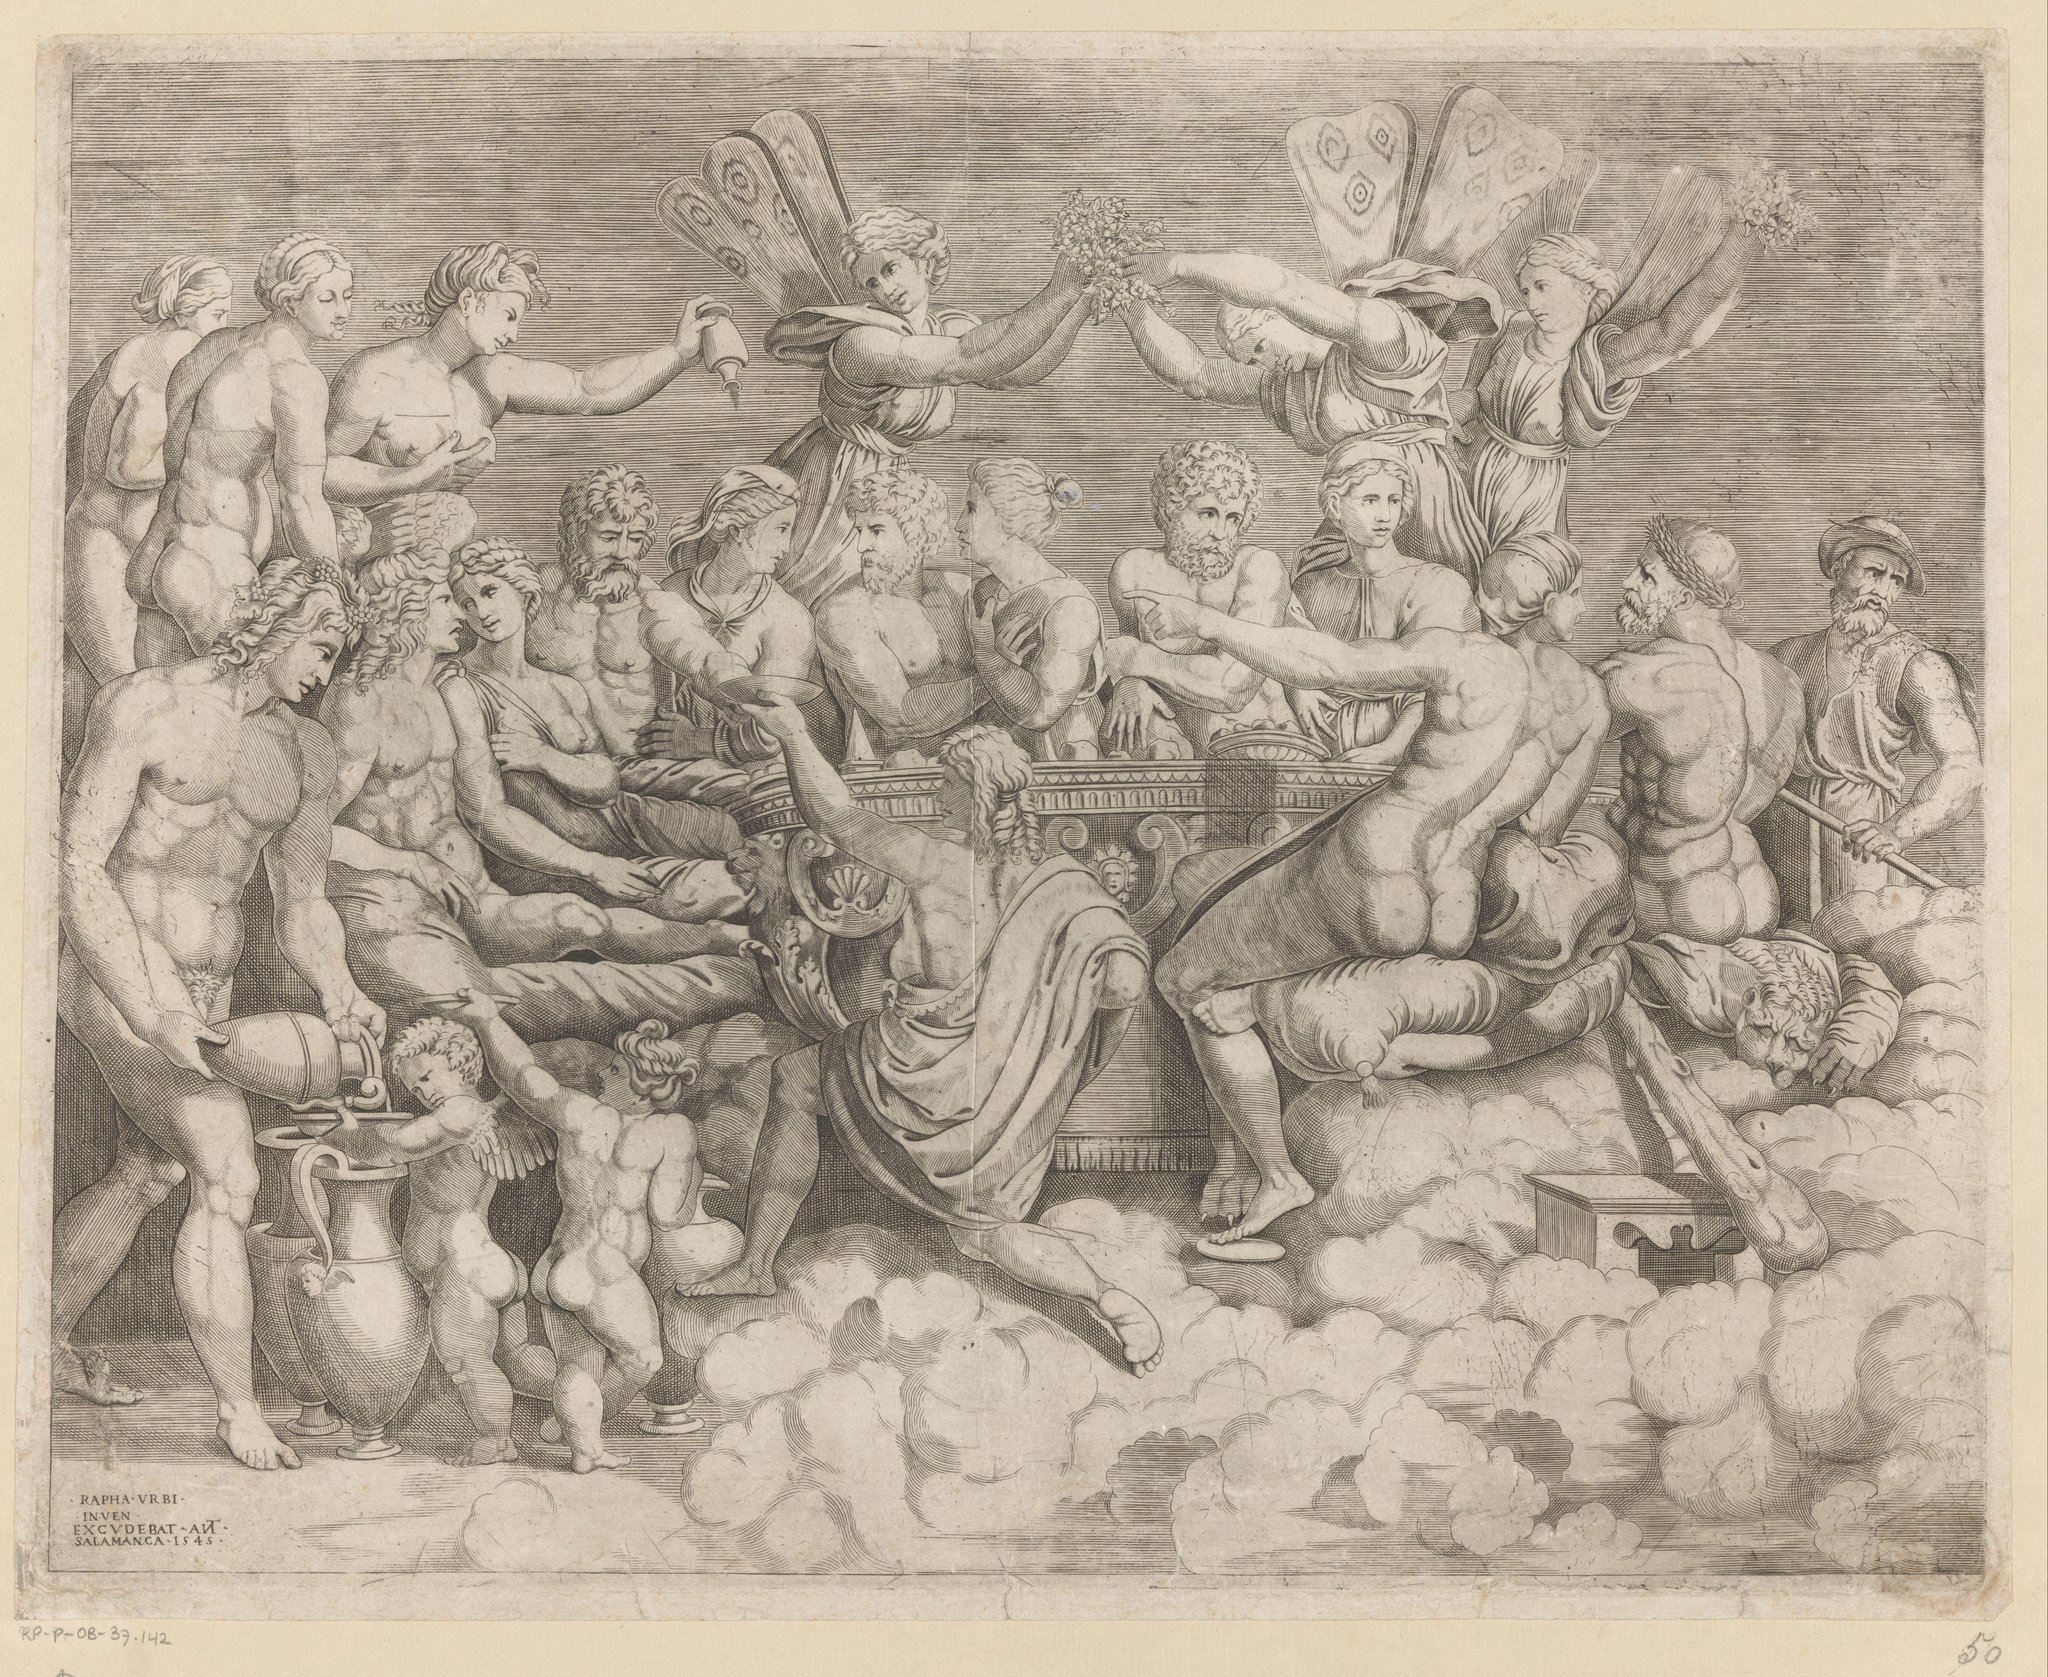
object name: print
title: De bruiloft van Psyche (linker deel)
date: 1545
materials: paper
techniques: engraving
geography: rome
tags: marriage of cupid and psyche, banquets, feasts of the gods (in the air, possibly on the clouds)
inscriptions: collector's mark: Lugt 240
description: Naar een plafondschildering door Rafaël in de Villa Farnesina te Rome. Linkerhelft van een grotere prent, gedrukt van twee platen meestal op twee bladen.